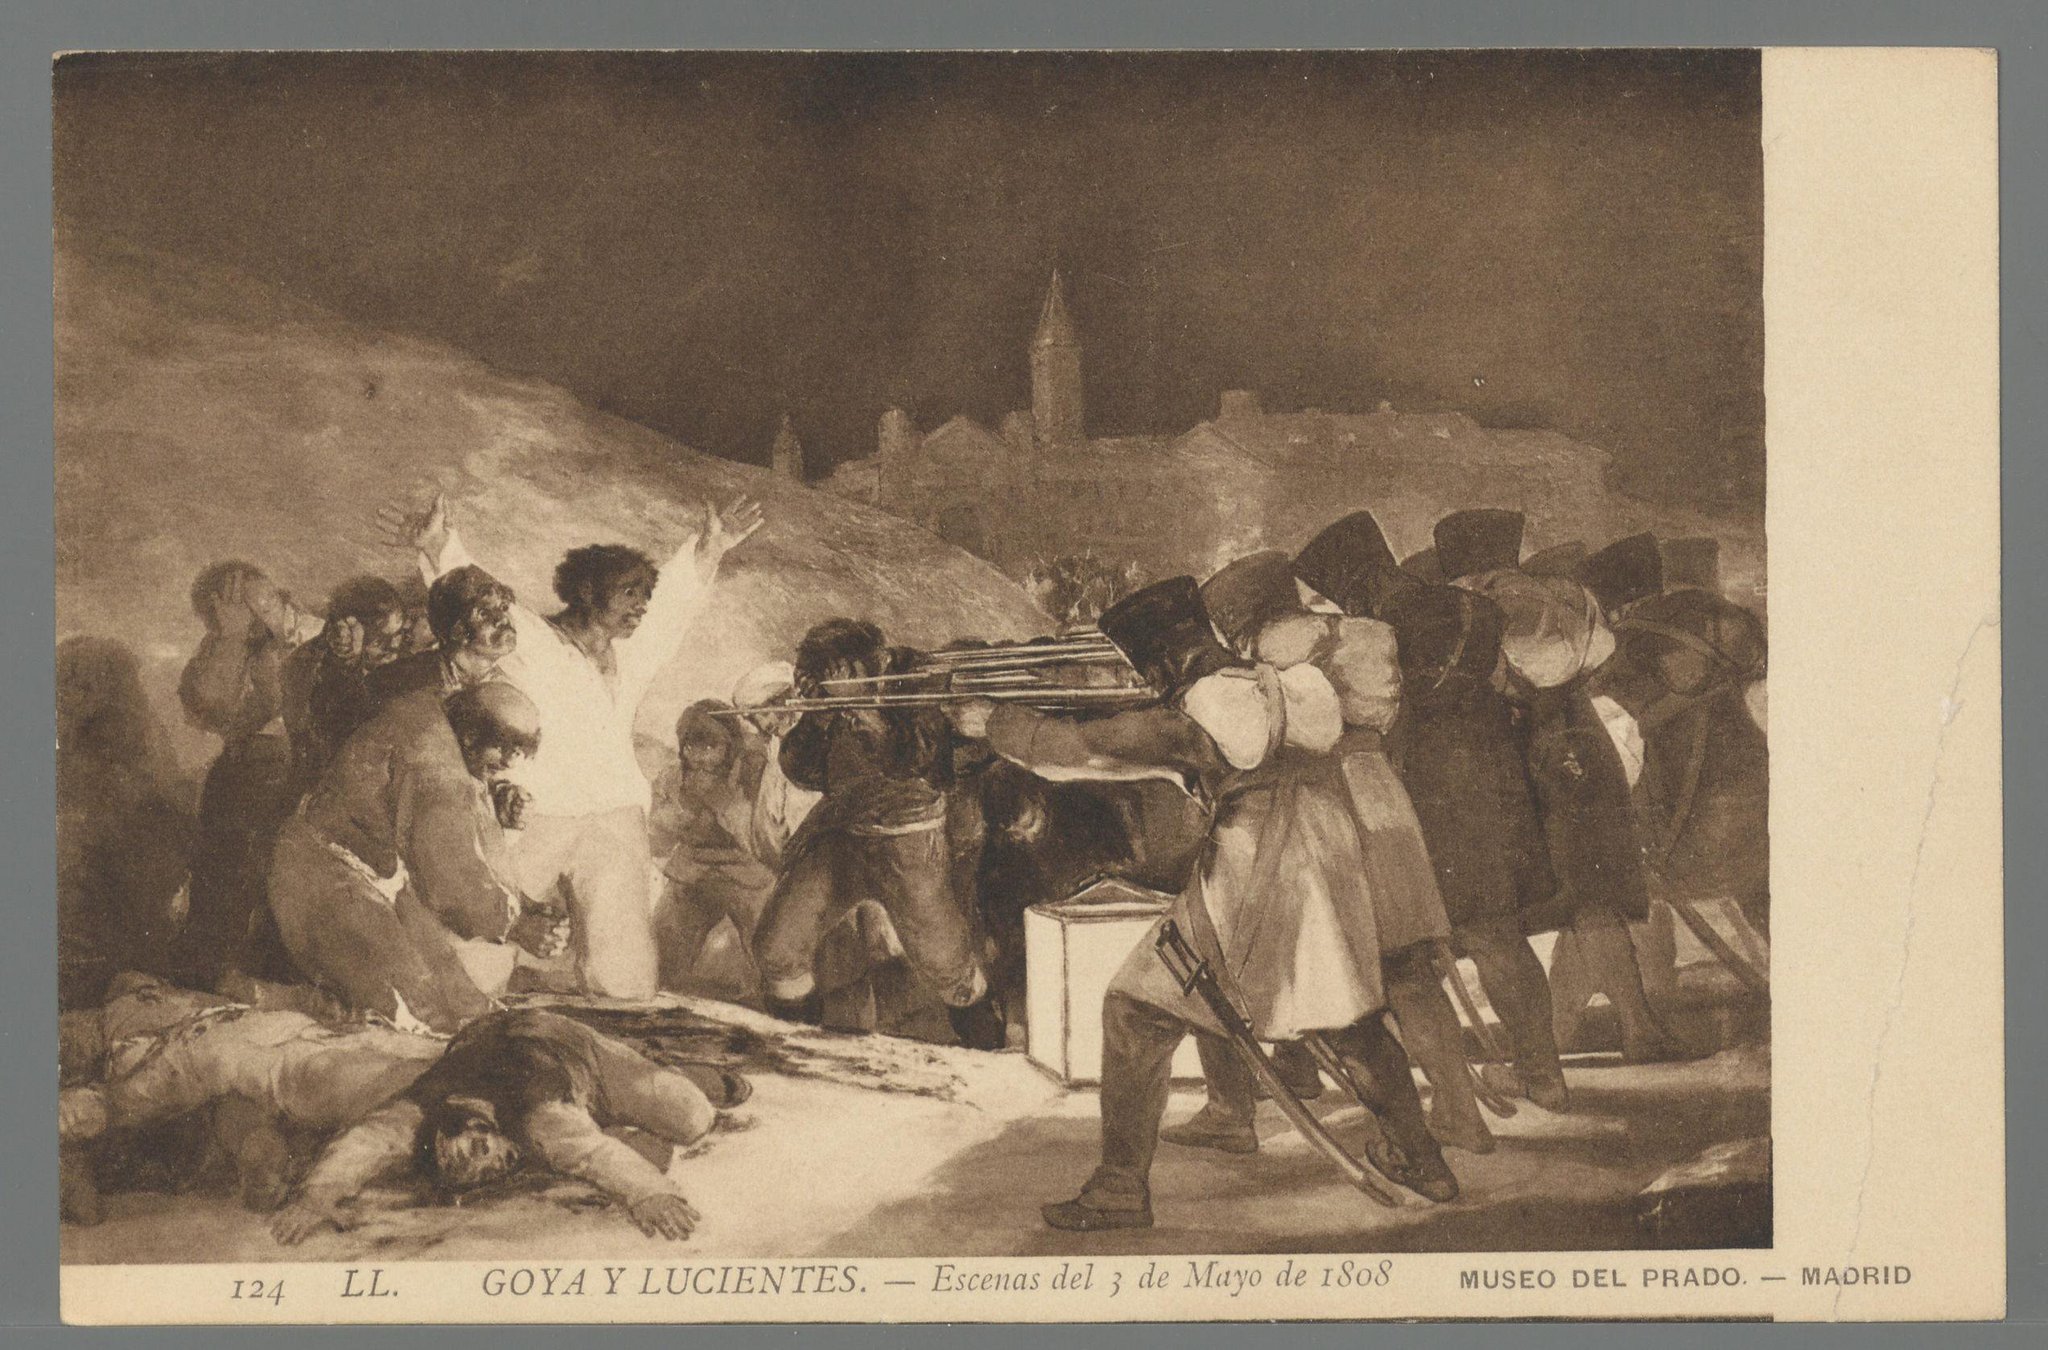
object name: reproduction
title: Escenas del 3 de Mayo de 1808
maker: francisco de goya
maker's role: draughtsman, painter, print maker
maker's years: 1746-1828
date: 1905-1920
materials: cardboard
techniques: photograph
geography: paris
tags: firearms, war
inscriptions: stamp: ‘M. Palomeque. Arenal, 17. Madrid’, collector's mark: ‘AFE v S’